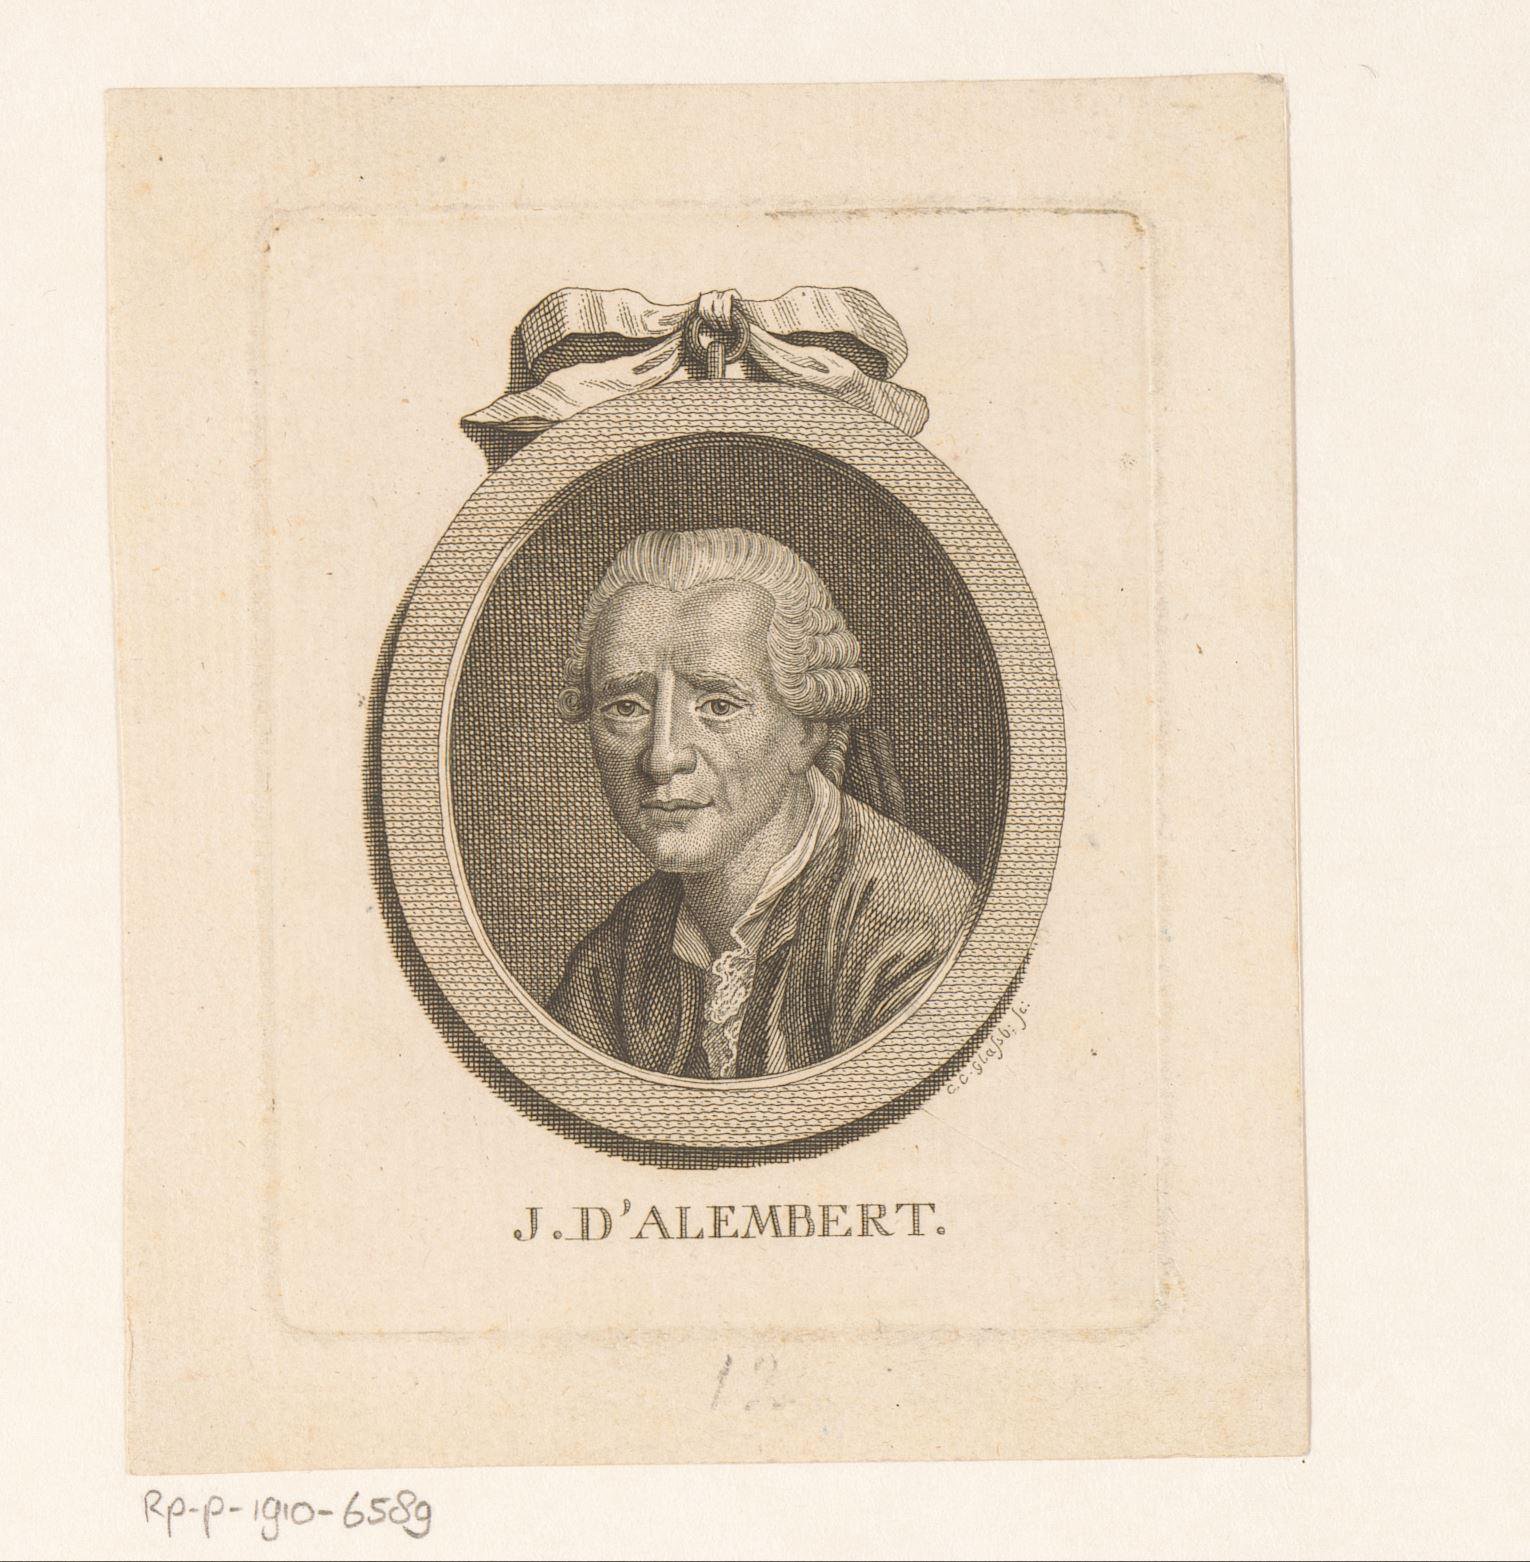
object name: print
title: Portret van Jean Le Rond d'Alembert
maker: carl christian glassbach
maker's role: print maker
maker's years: 1751-1789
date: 1761-1789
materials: paper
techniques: engraving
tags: paris, physicist, scholar, philosopher, ornament ~ medallion, historical persons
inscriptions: collector's mark: Lugt 2228, collector's mark: Lugt 1388